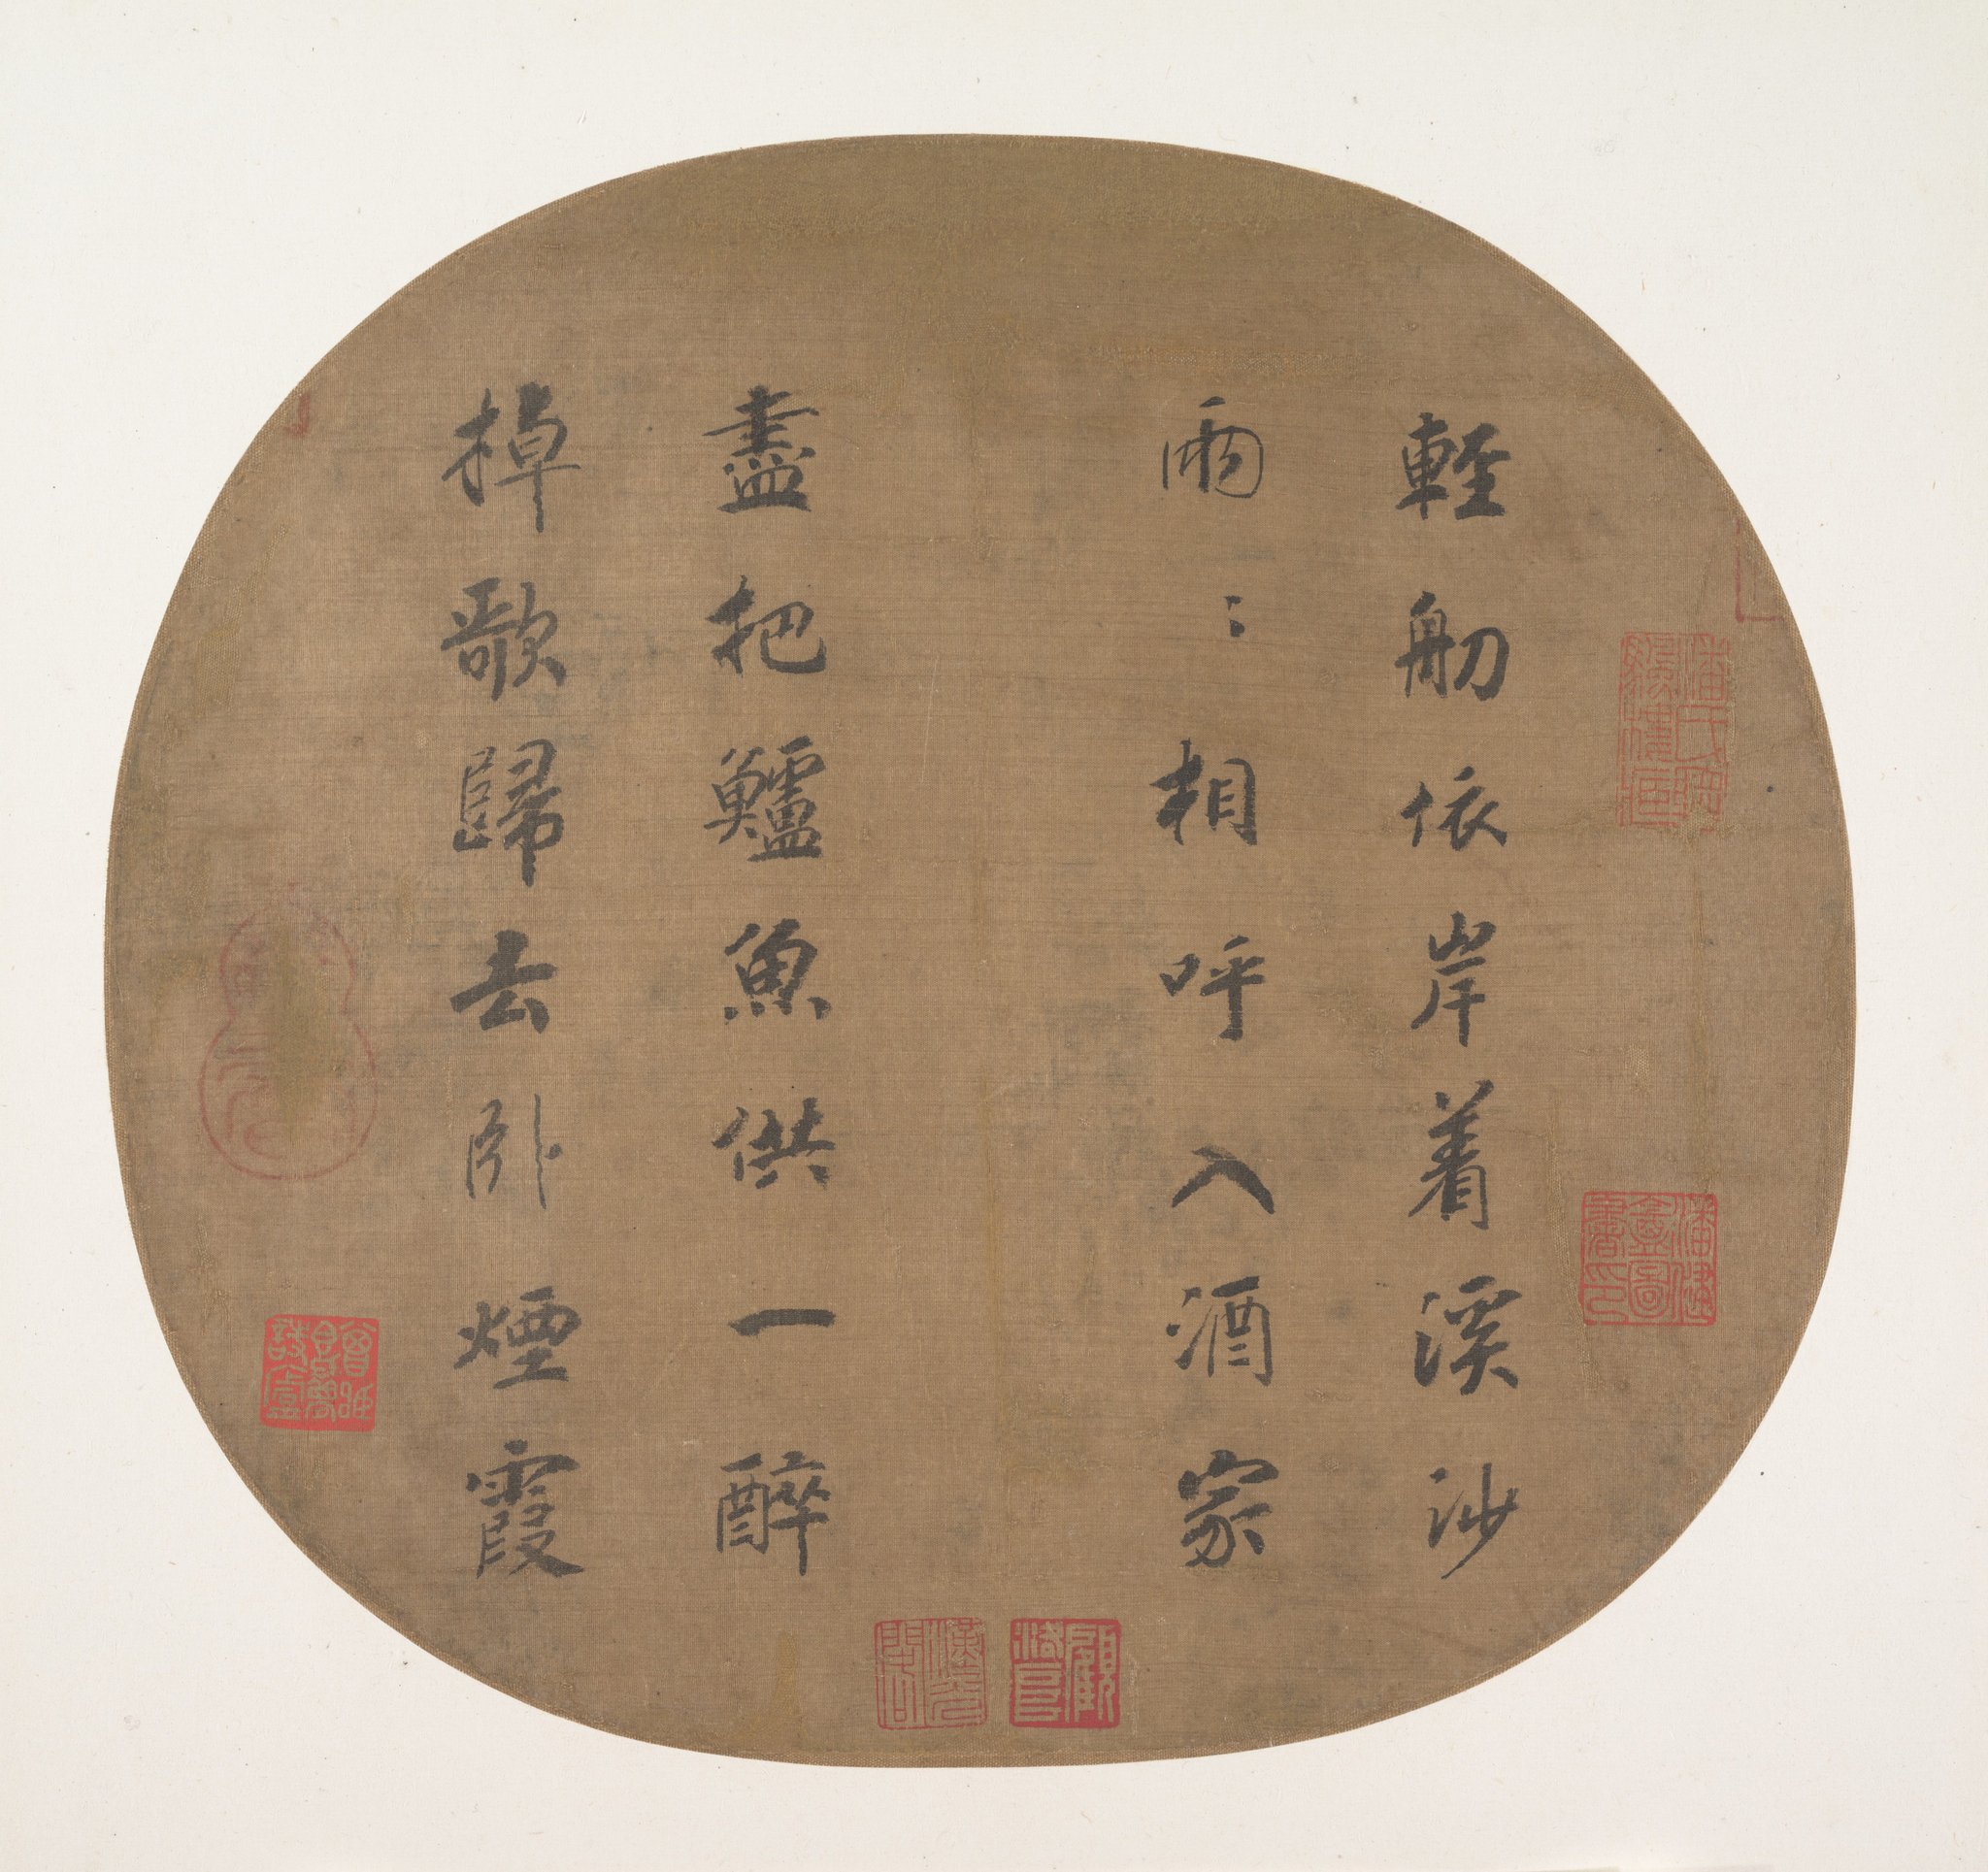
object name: fan mounted a an album leaf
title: Quatrain on fishermen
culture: chinese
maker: emperor gaozong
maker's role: artist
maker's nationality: chinese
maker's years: 1107-1187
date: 1101-1200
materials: ink, silk